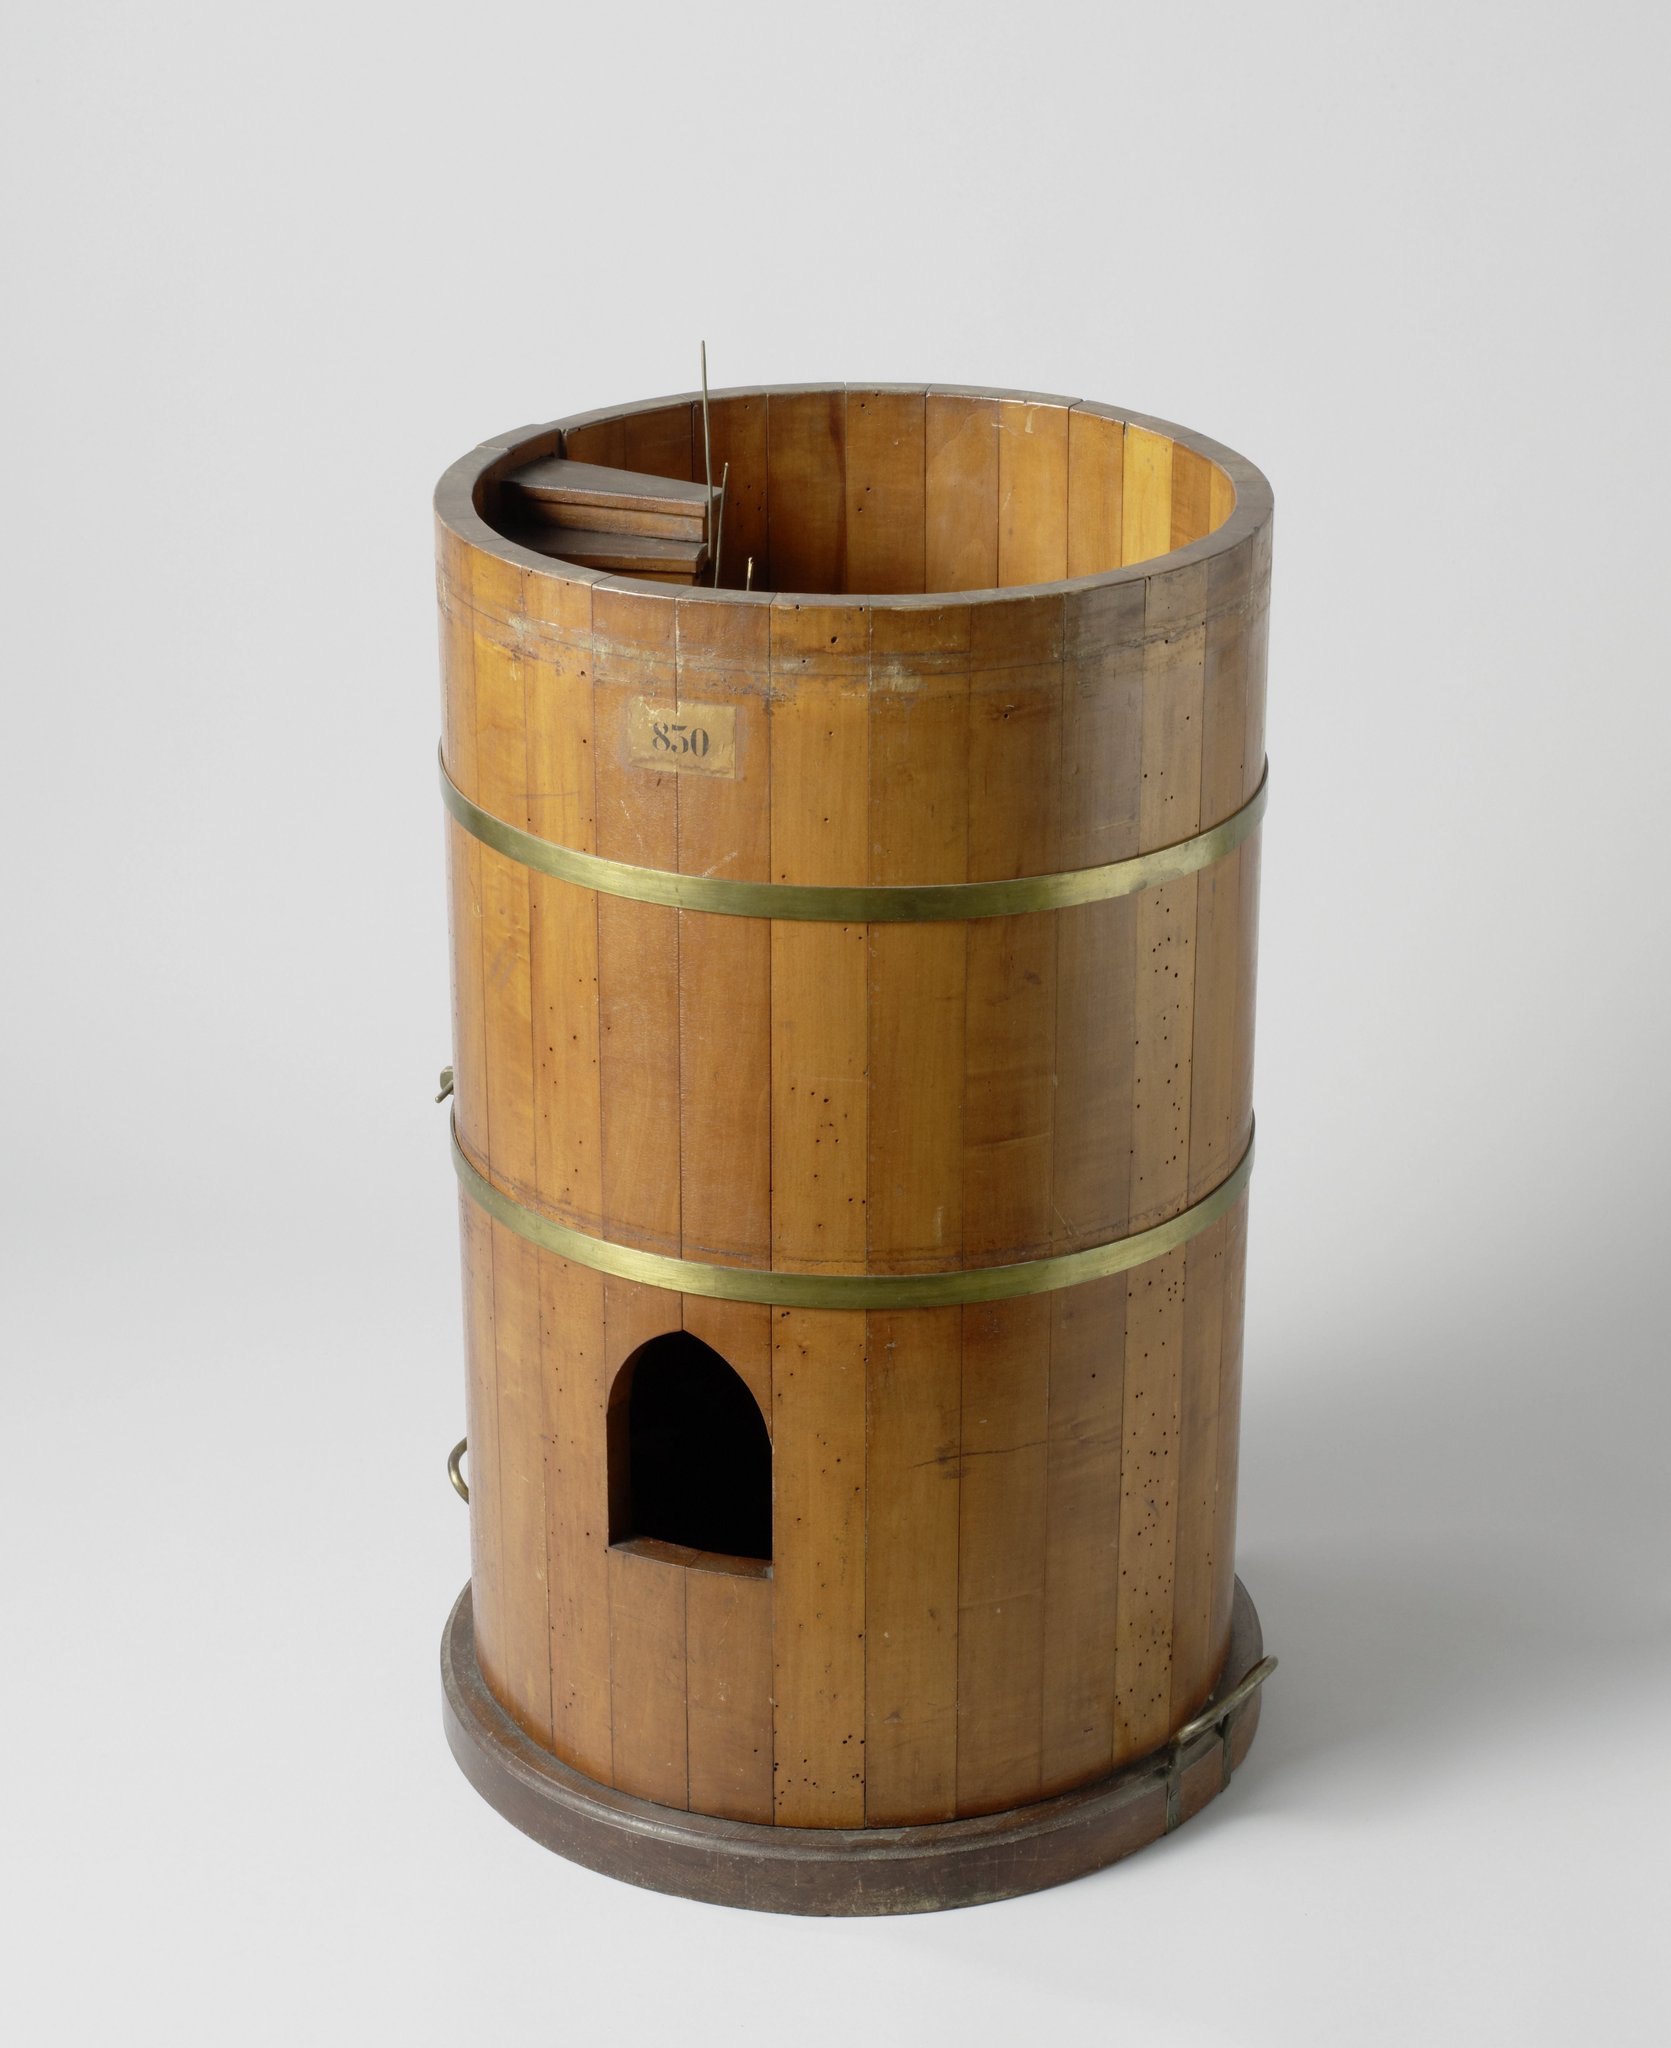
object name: demonstration model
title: Model of the Spiral Staircase of a Lighthouse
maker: petrus van der loo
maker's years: 1806-1864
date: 1834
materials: brass, wood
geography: netherlands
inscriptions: label, top: ‘830’ former inventory label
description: Dit is het model van de wenteltrap van de vuurtoren van Haamstede op het noordwesten van het eiland Schouwen, hoog 47 m, diam. 11-5.3 m, ontworpen door L. Valk en gebouwd in 1837-1840 door J.G. Palada uit Vreeswijk, met lichten van de geschutgieterij Maritz & Zoon uit Den Haag. De draaiende beweging van het optiek werd verzorgd door een uurwerk met een zwaar gewicht, dat in de binnenkoker vrij naar beneden kon zakken: hiervoor moest de trap een gat in het midden vrijlaten. Onderin de binnenkoker stond een bak met stro om het gewicht op te vangen indien het koord zou breken.